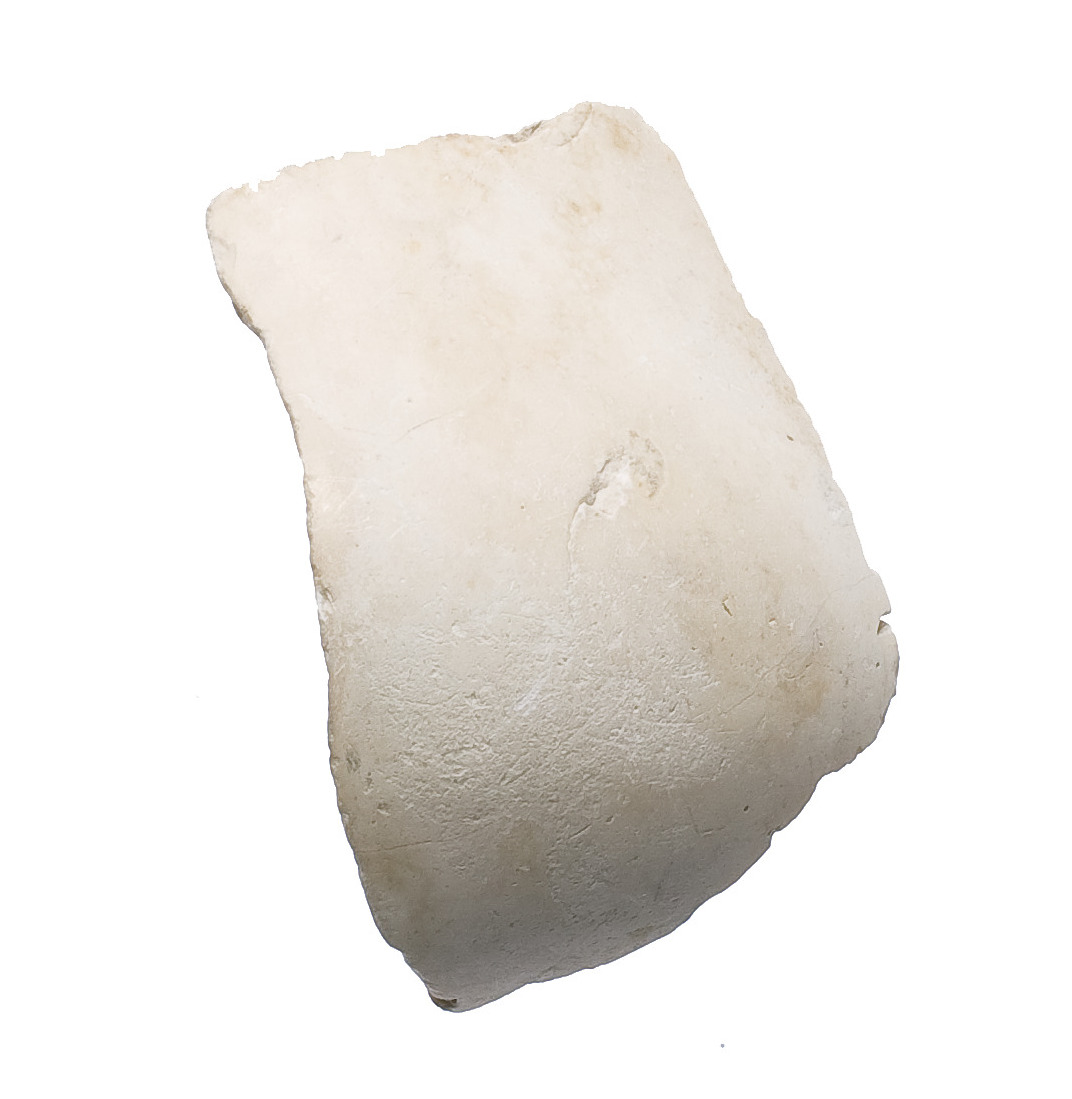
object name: elbow or shoulder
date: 1353-1336 BCE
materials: limestone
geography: egypt